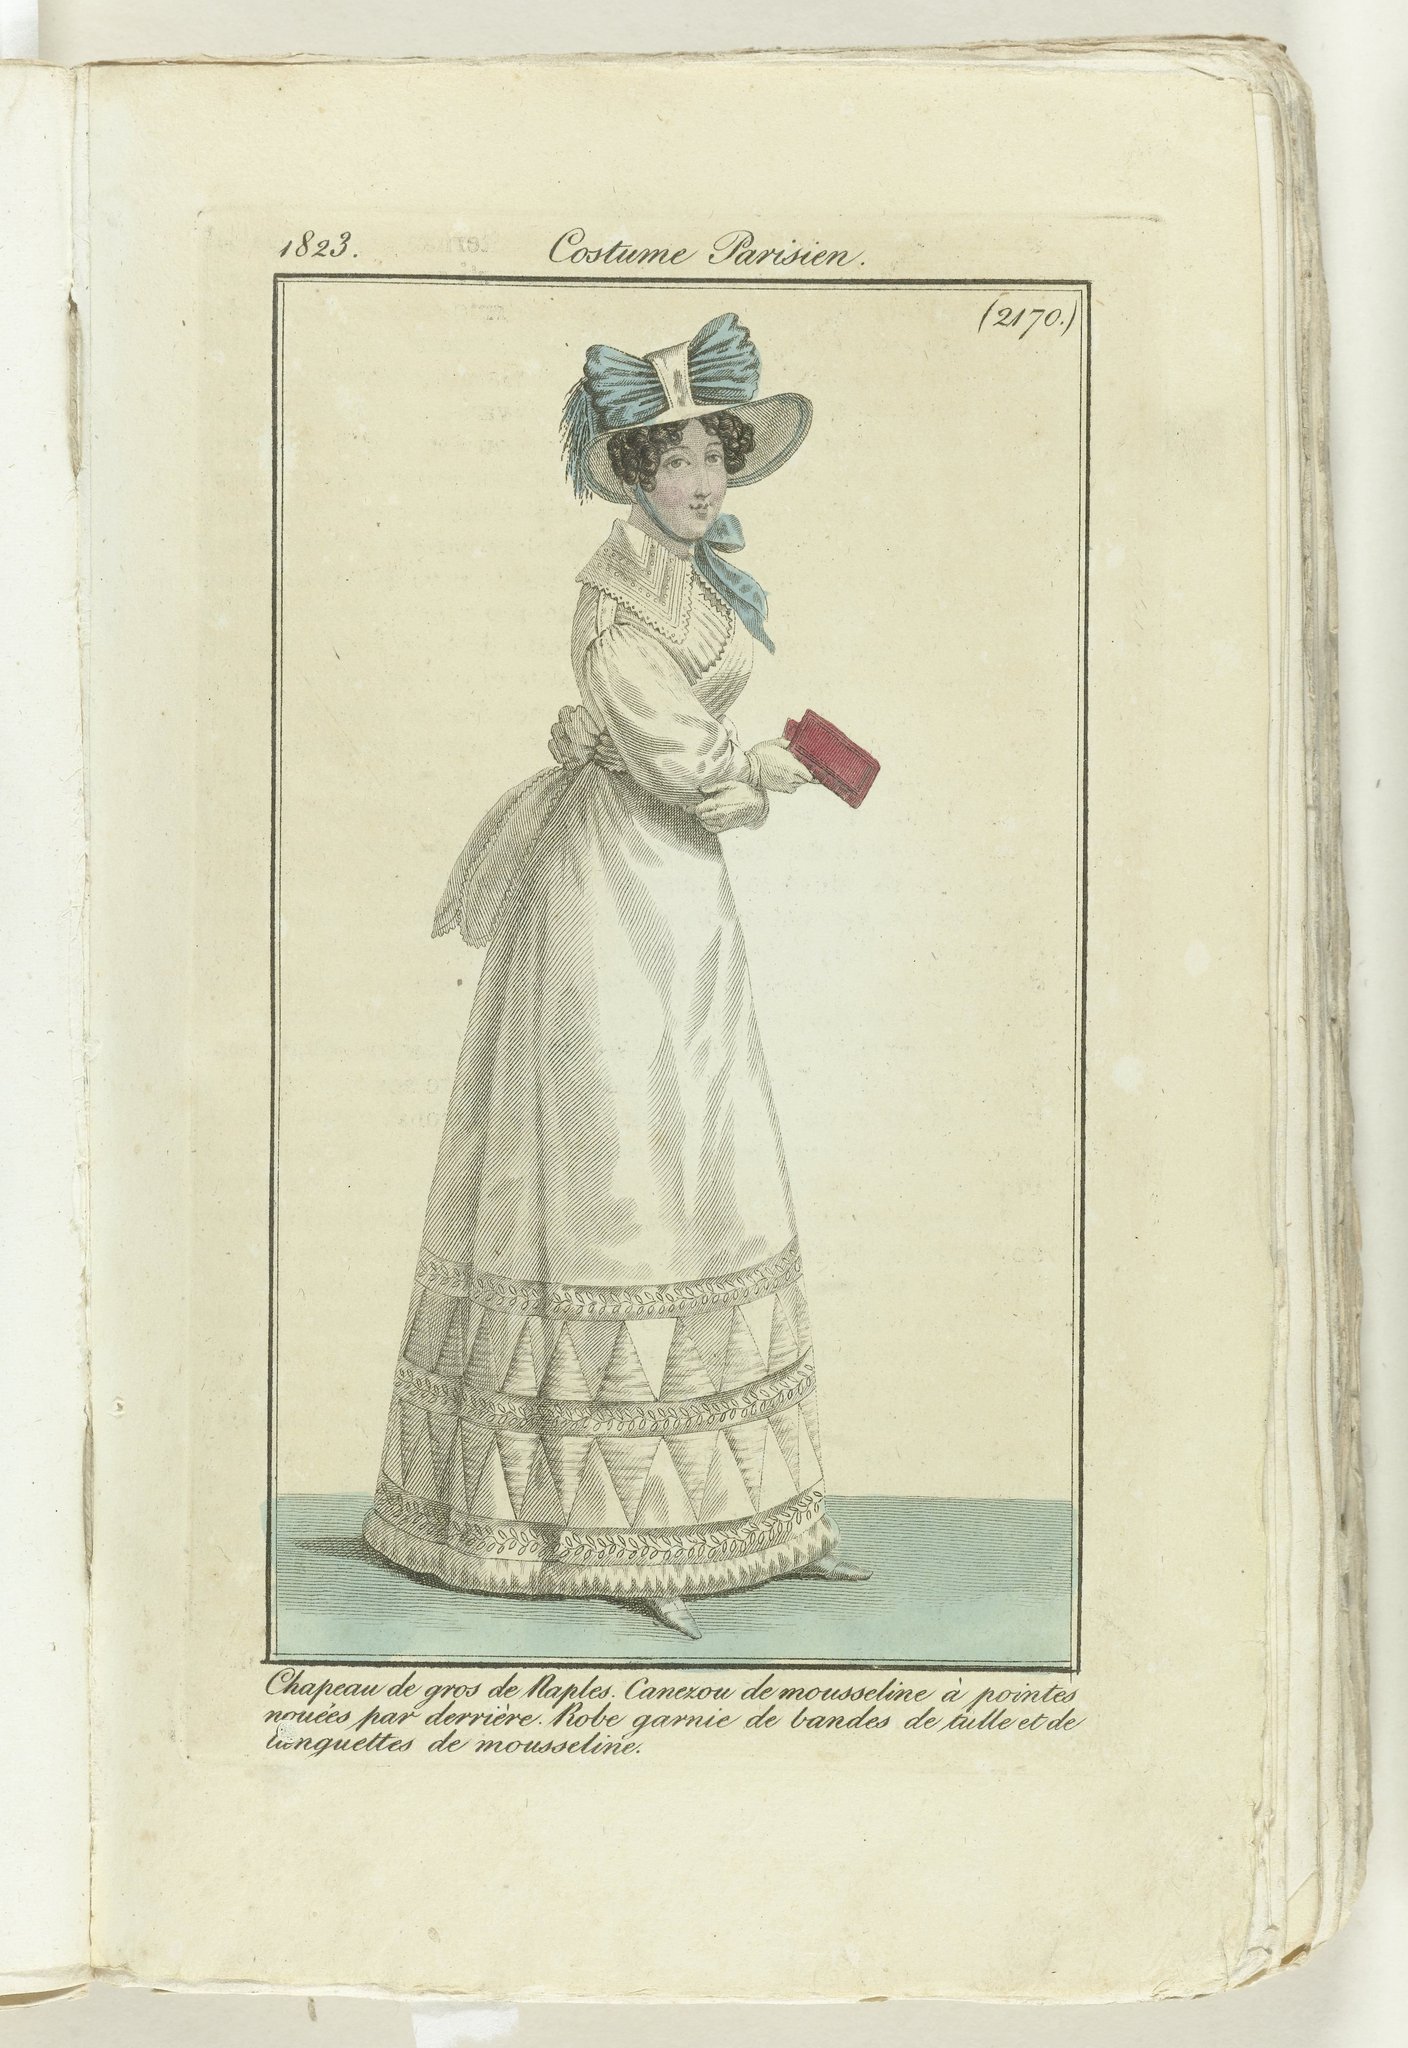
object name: fashion print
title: Journal des Dames et des Modes 1823, Costume Parisien (2170)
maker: Anonymous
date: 1823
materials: paper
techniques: etching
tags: fashion plates, clothes, costume (+ women's clothes)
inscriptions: date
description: Prent uit het tijdschrift Journal des Dames et des Modes, 1823.